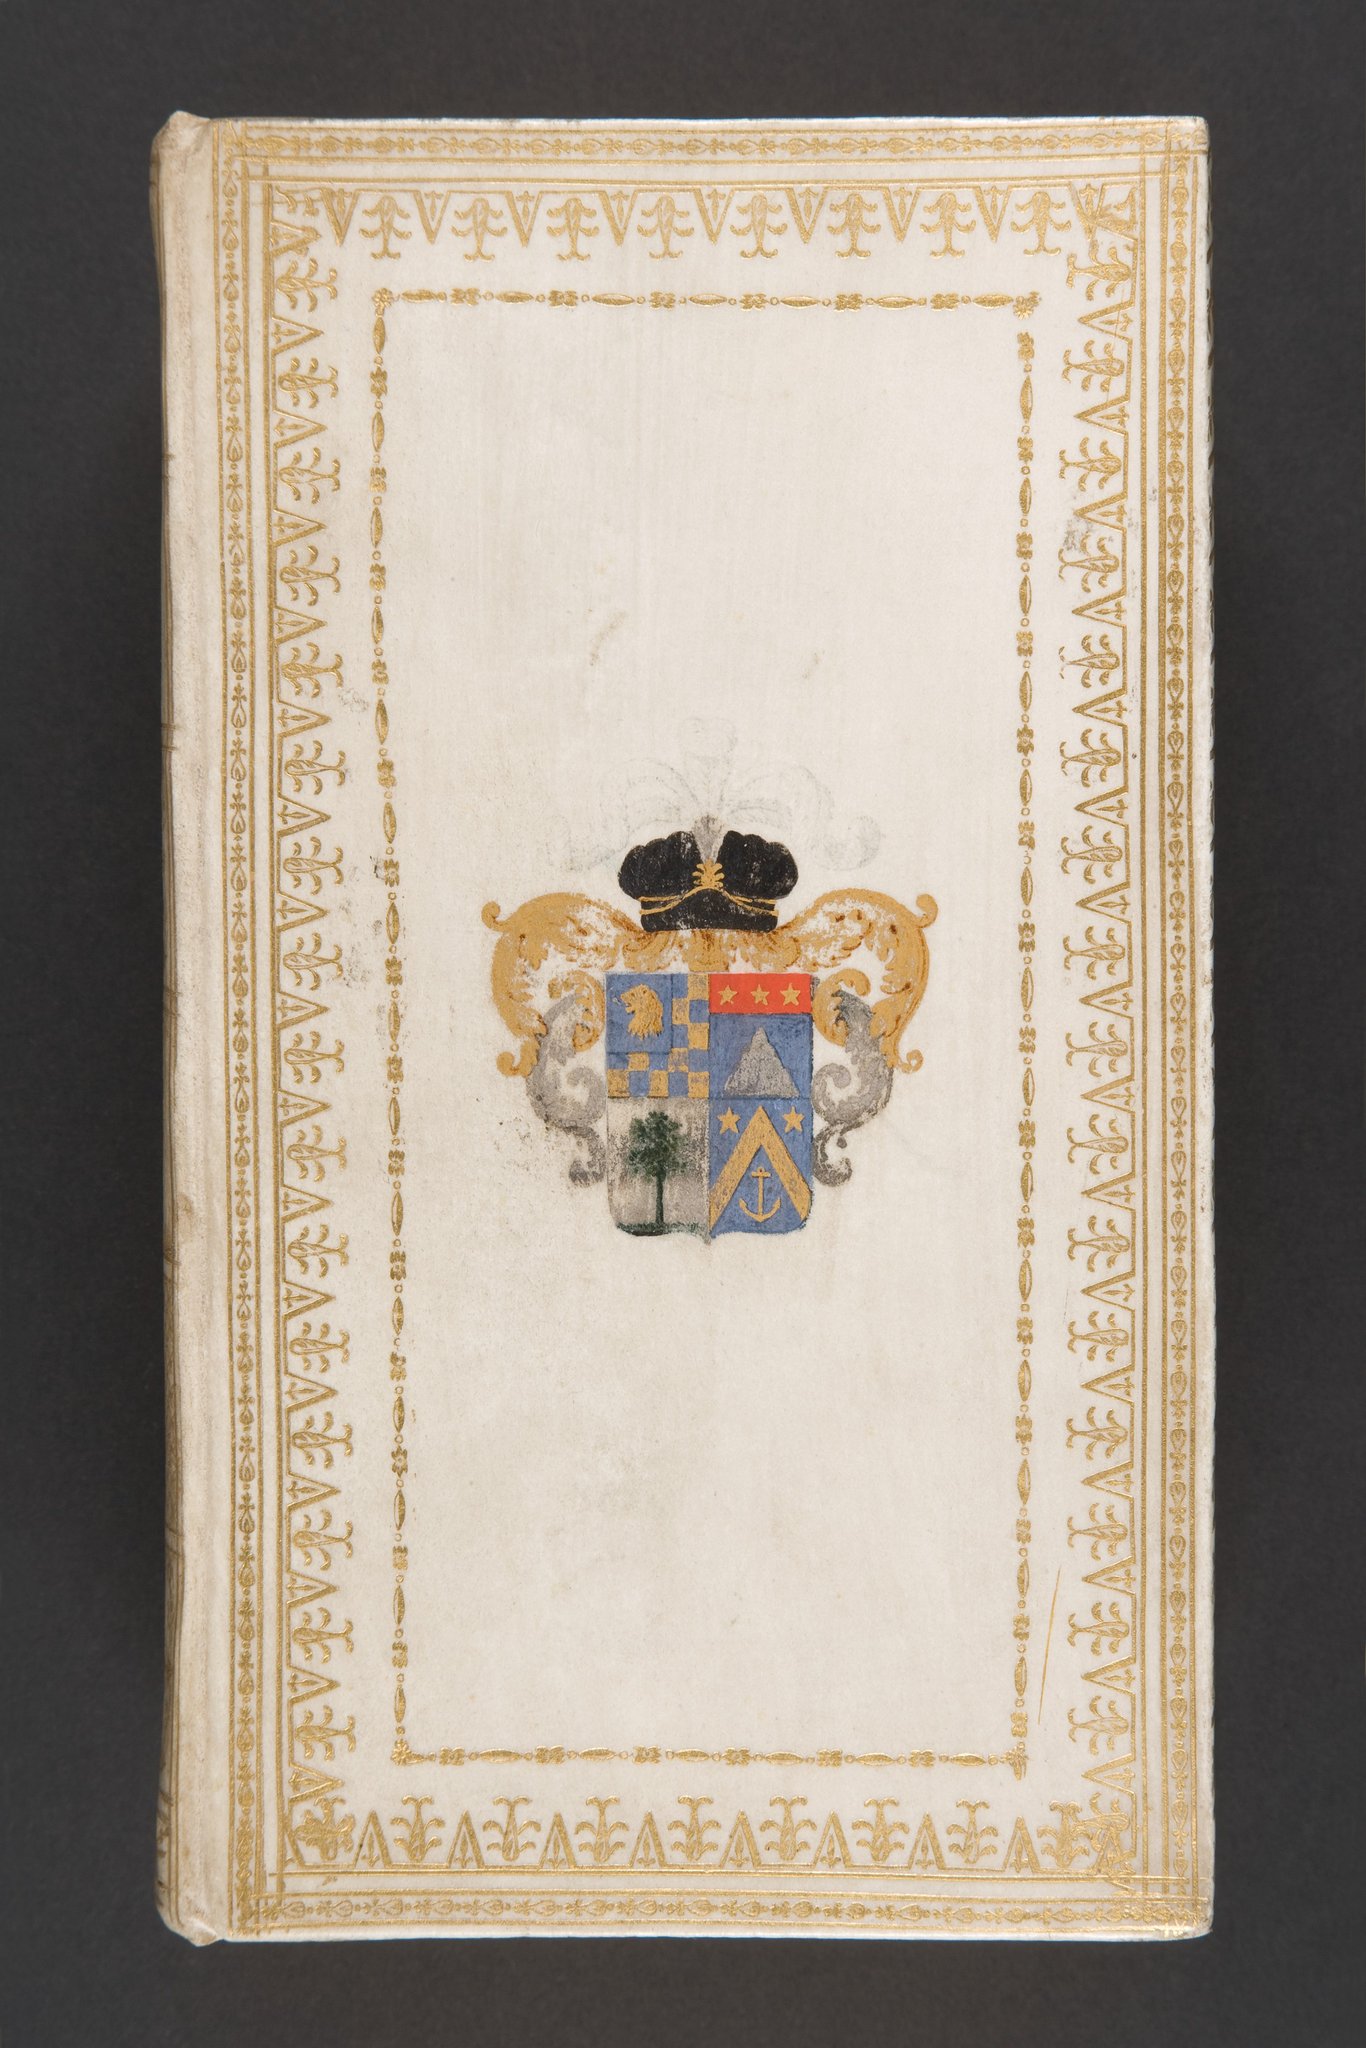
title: Almanach impérial, pour l'année M. DCCC. XIII présente a S. M. l'Empereur et Roi, par Testu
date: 1813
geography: france